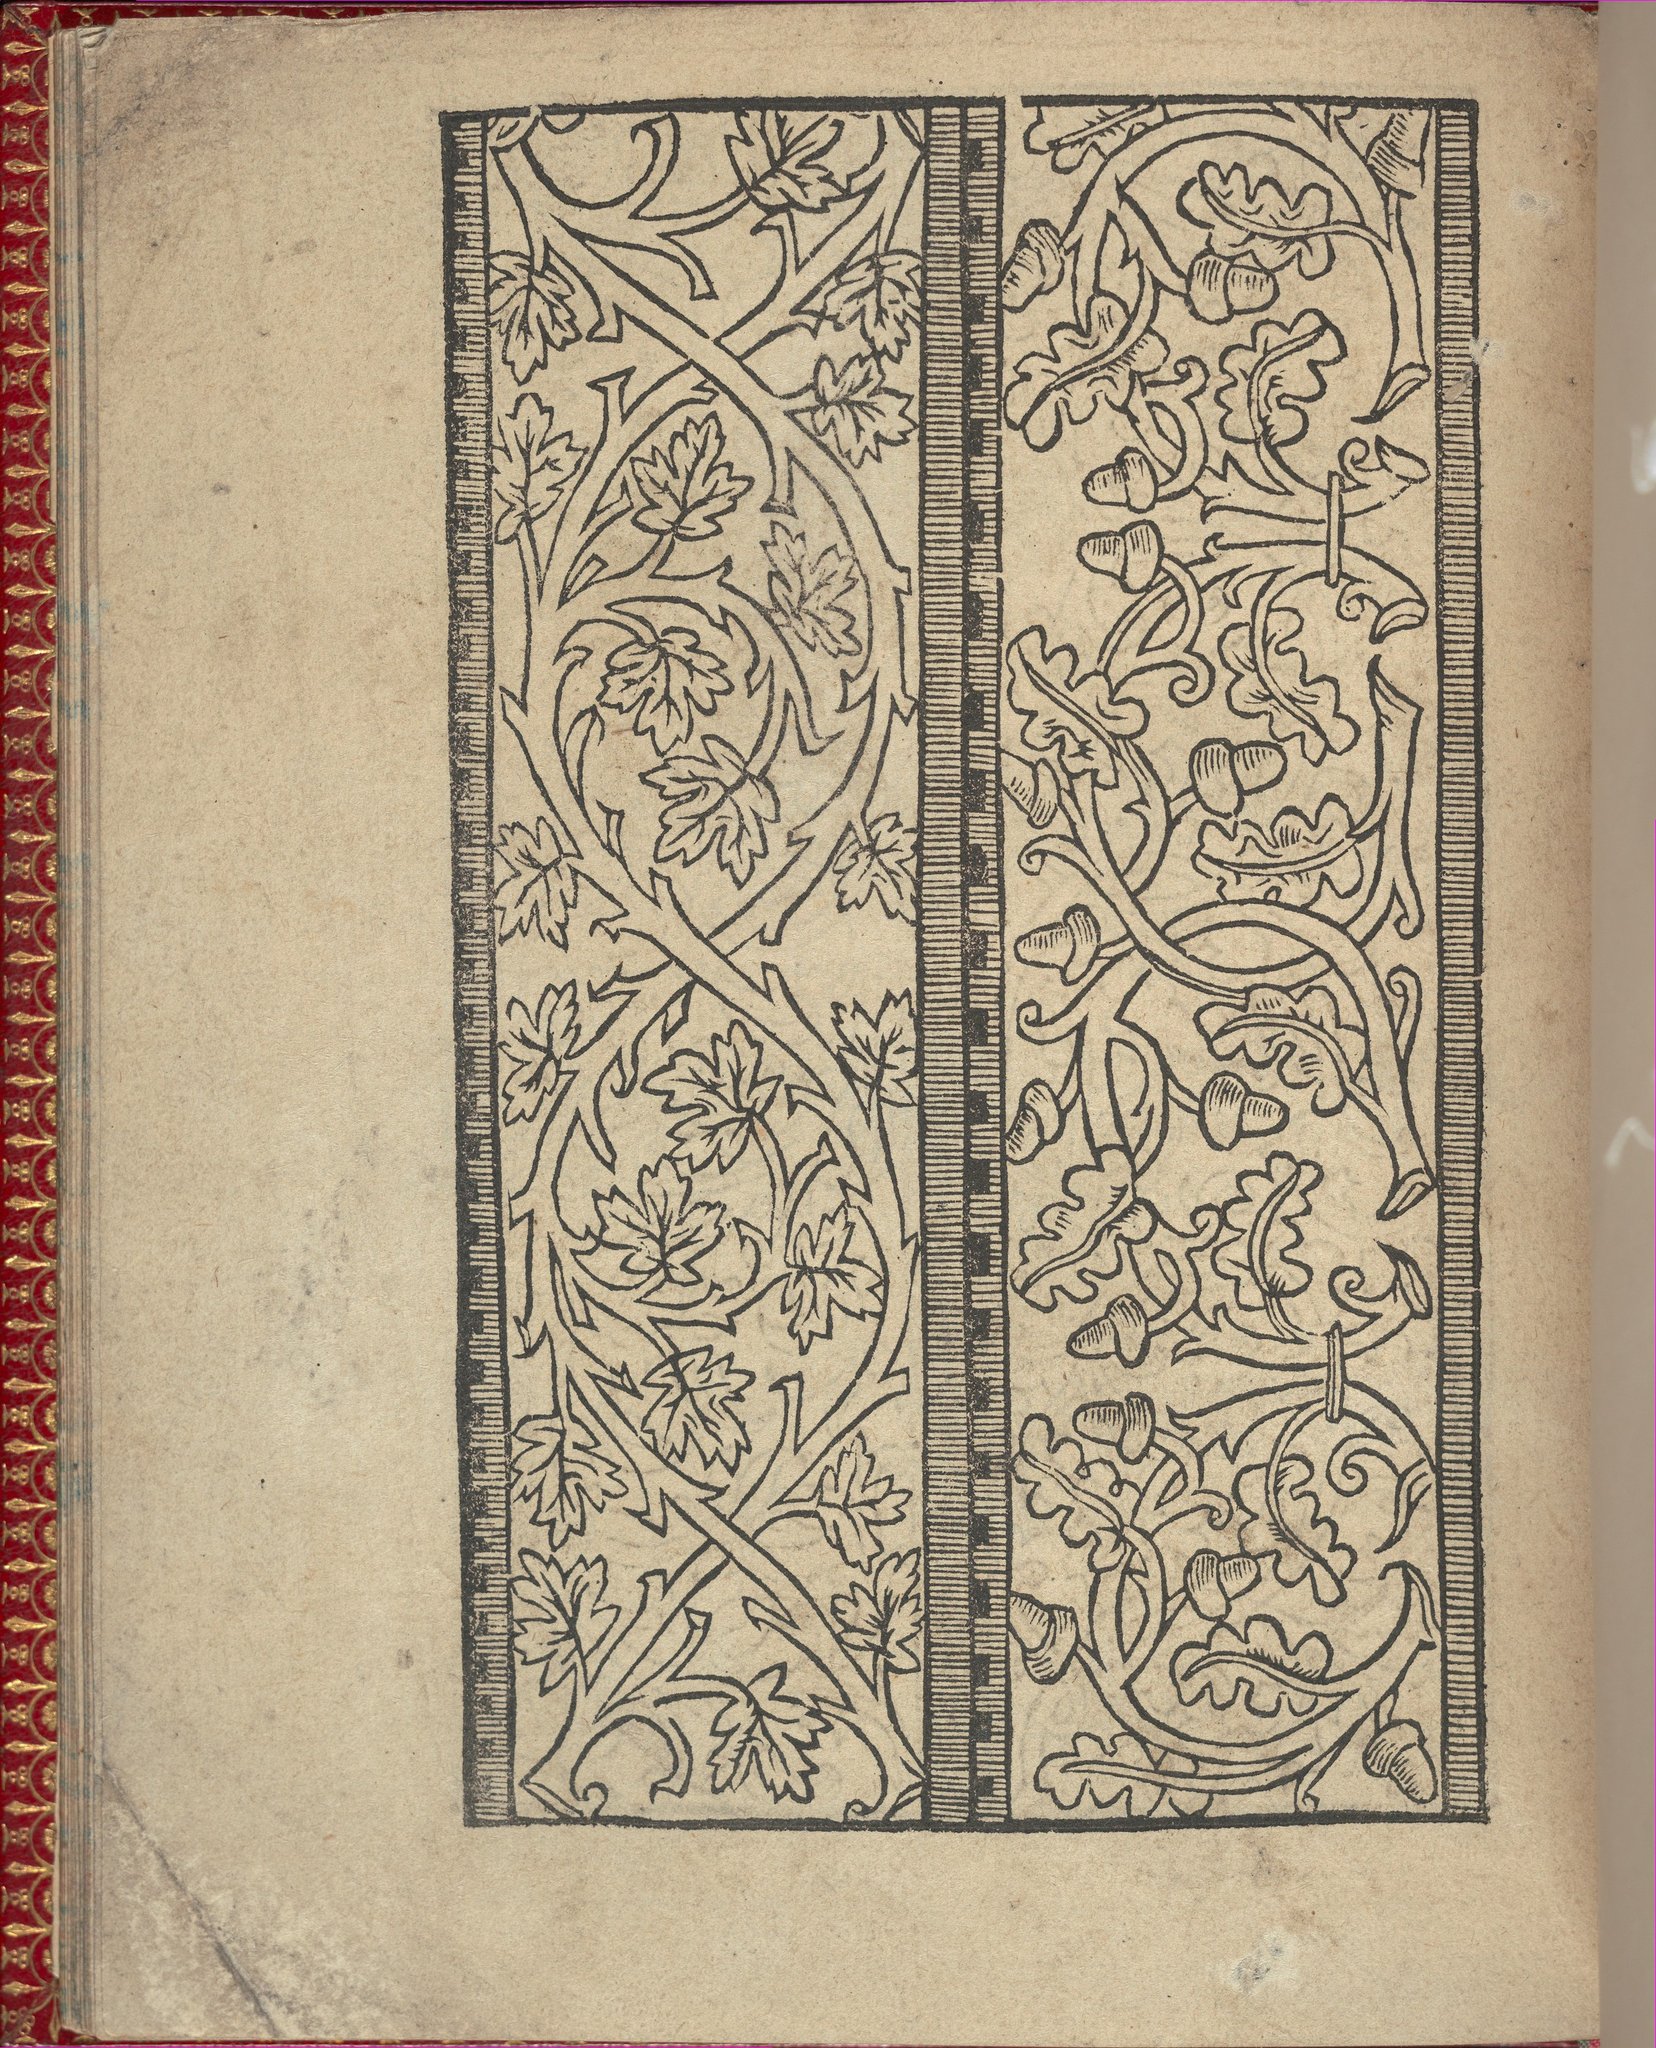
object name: book print ornament architecture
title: Ce est ung tractat de la noble art de leguille ascavoir ouvraiges de spaigne... page 23 (verso)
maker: willem vosterman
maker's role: printer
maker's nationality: netherlandish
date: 1527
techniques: woodcut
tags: acorns